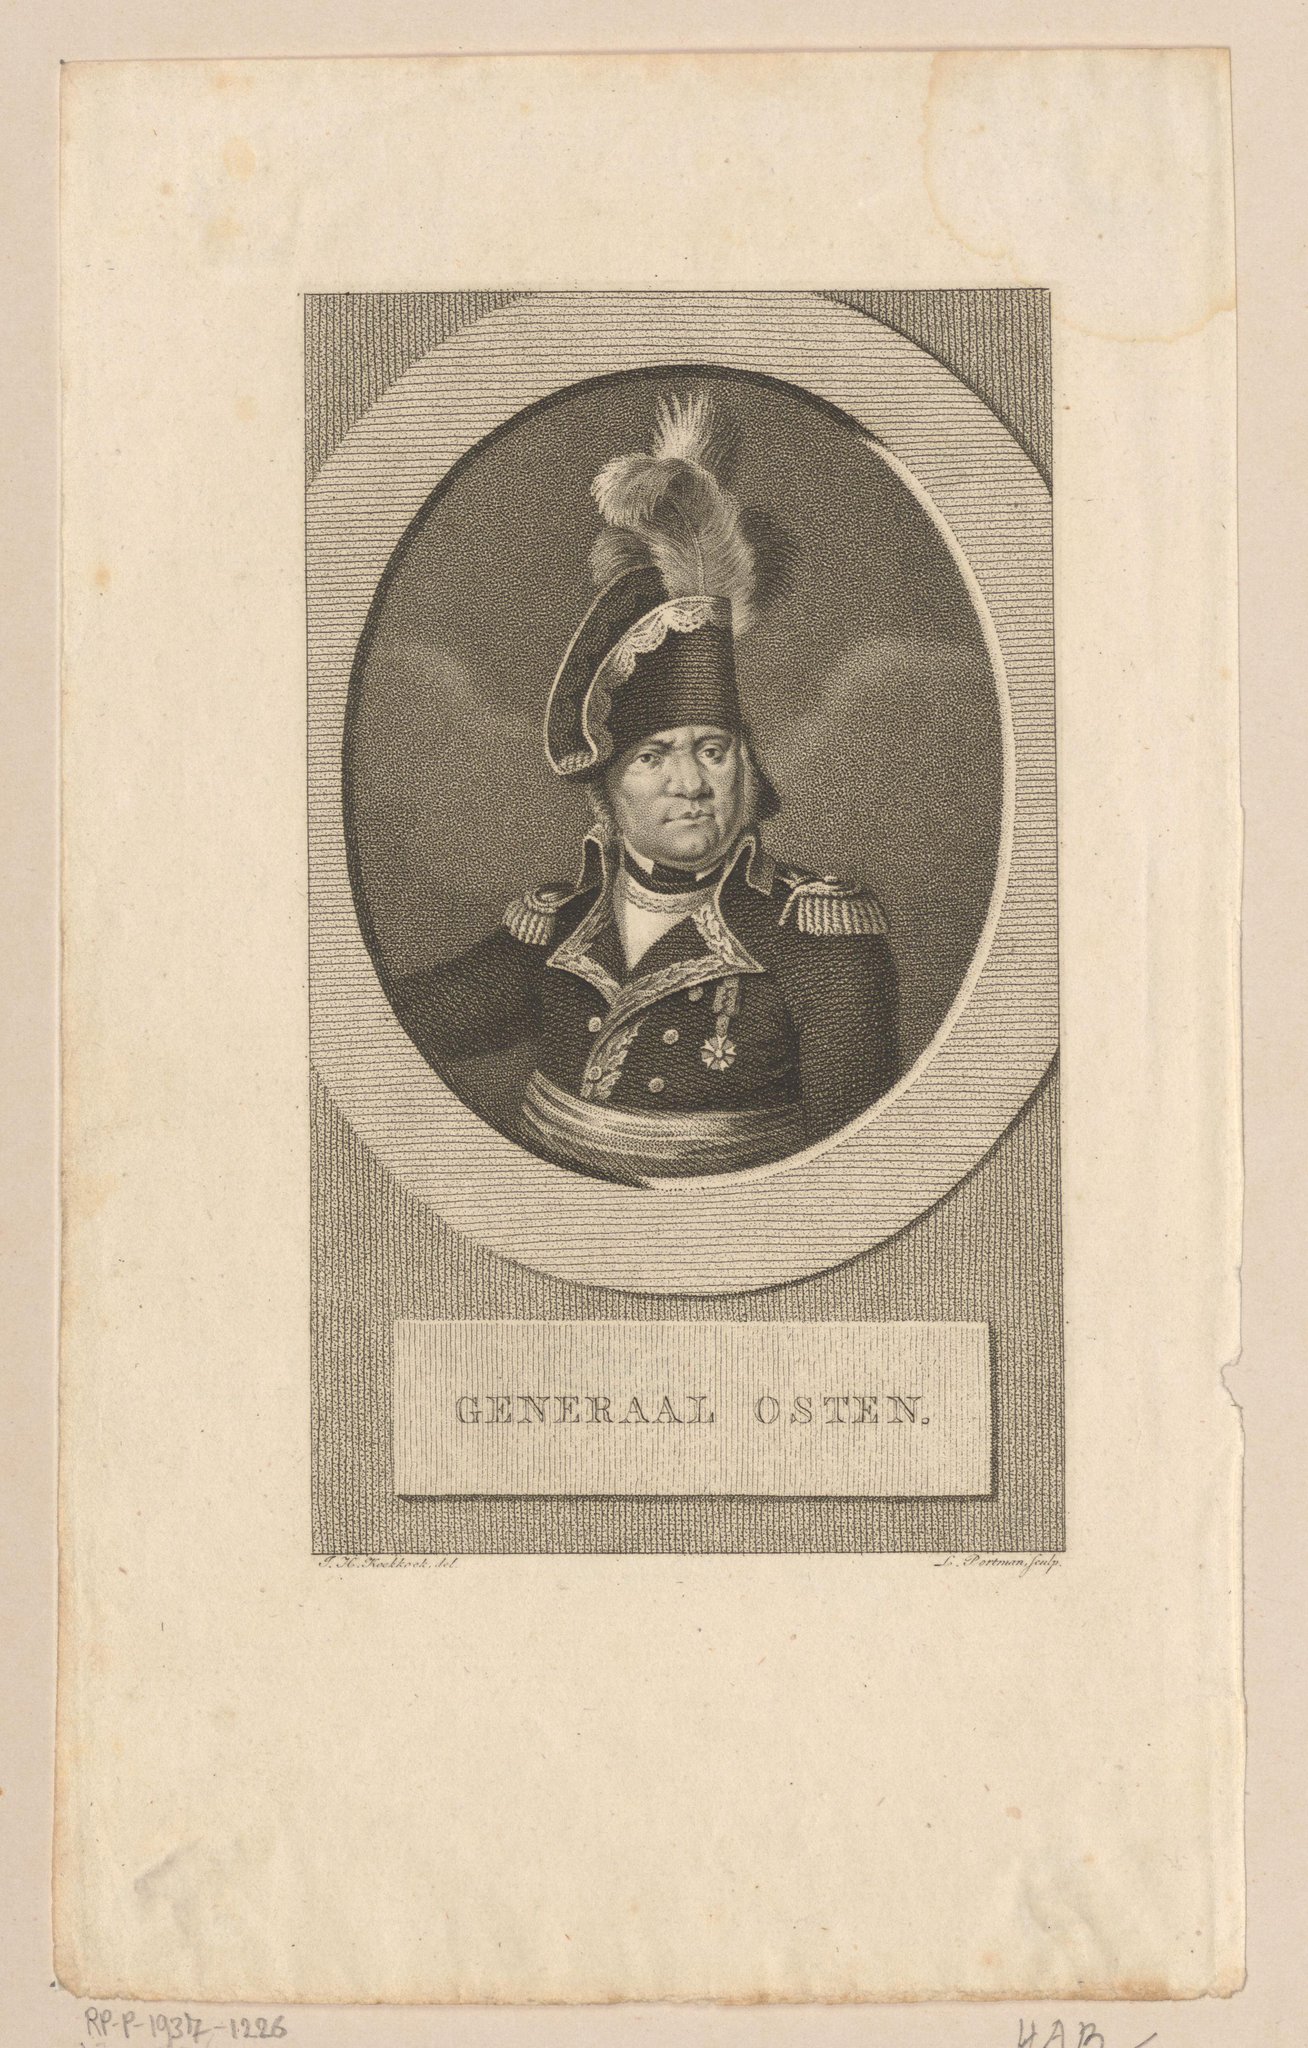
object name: print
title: Portret van Pierre-Jacques Osten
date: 1782-1828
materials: paper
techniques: etching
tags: historical persons, medals and other marks of military honour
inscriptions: collector's mark: Lugt 2228